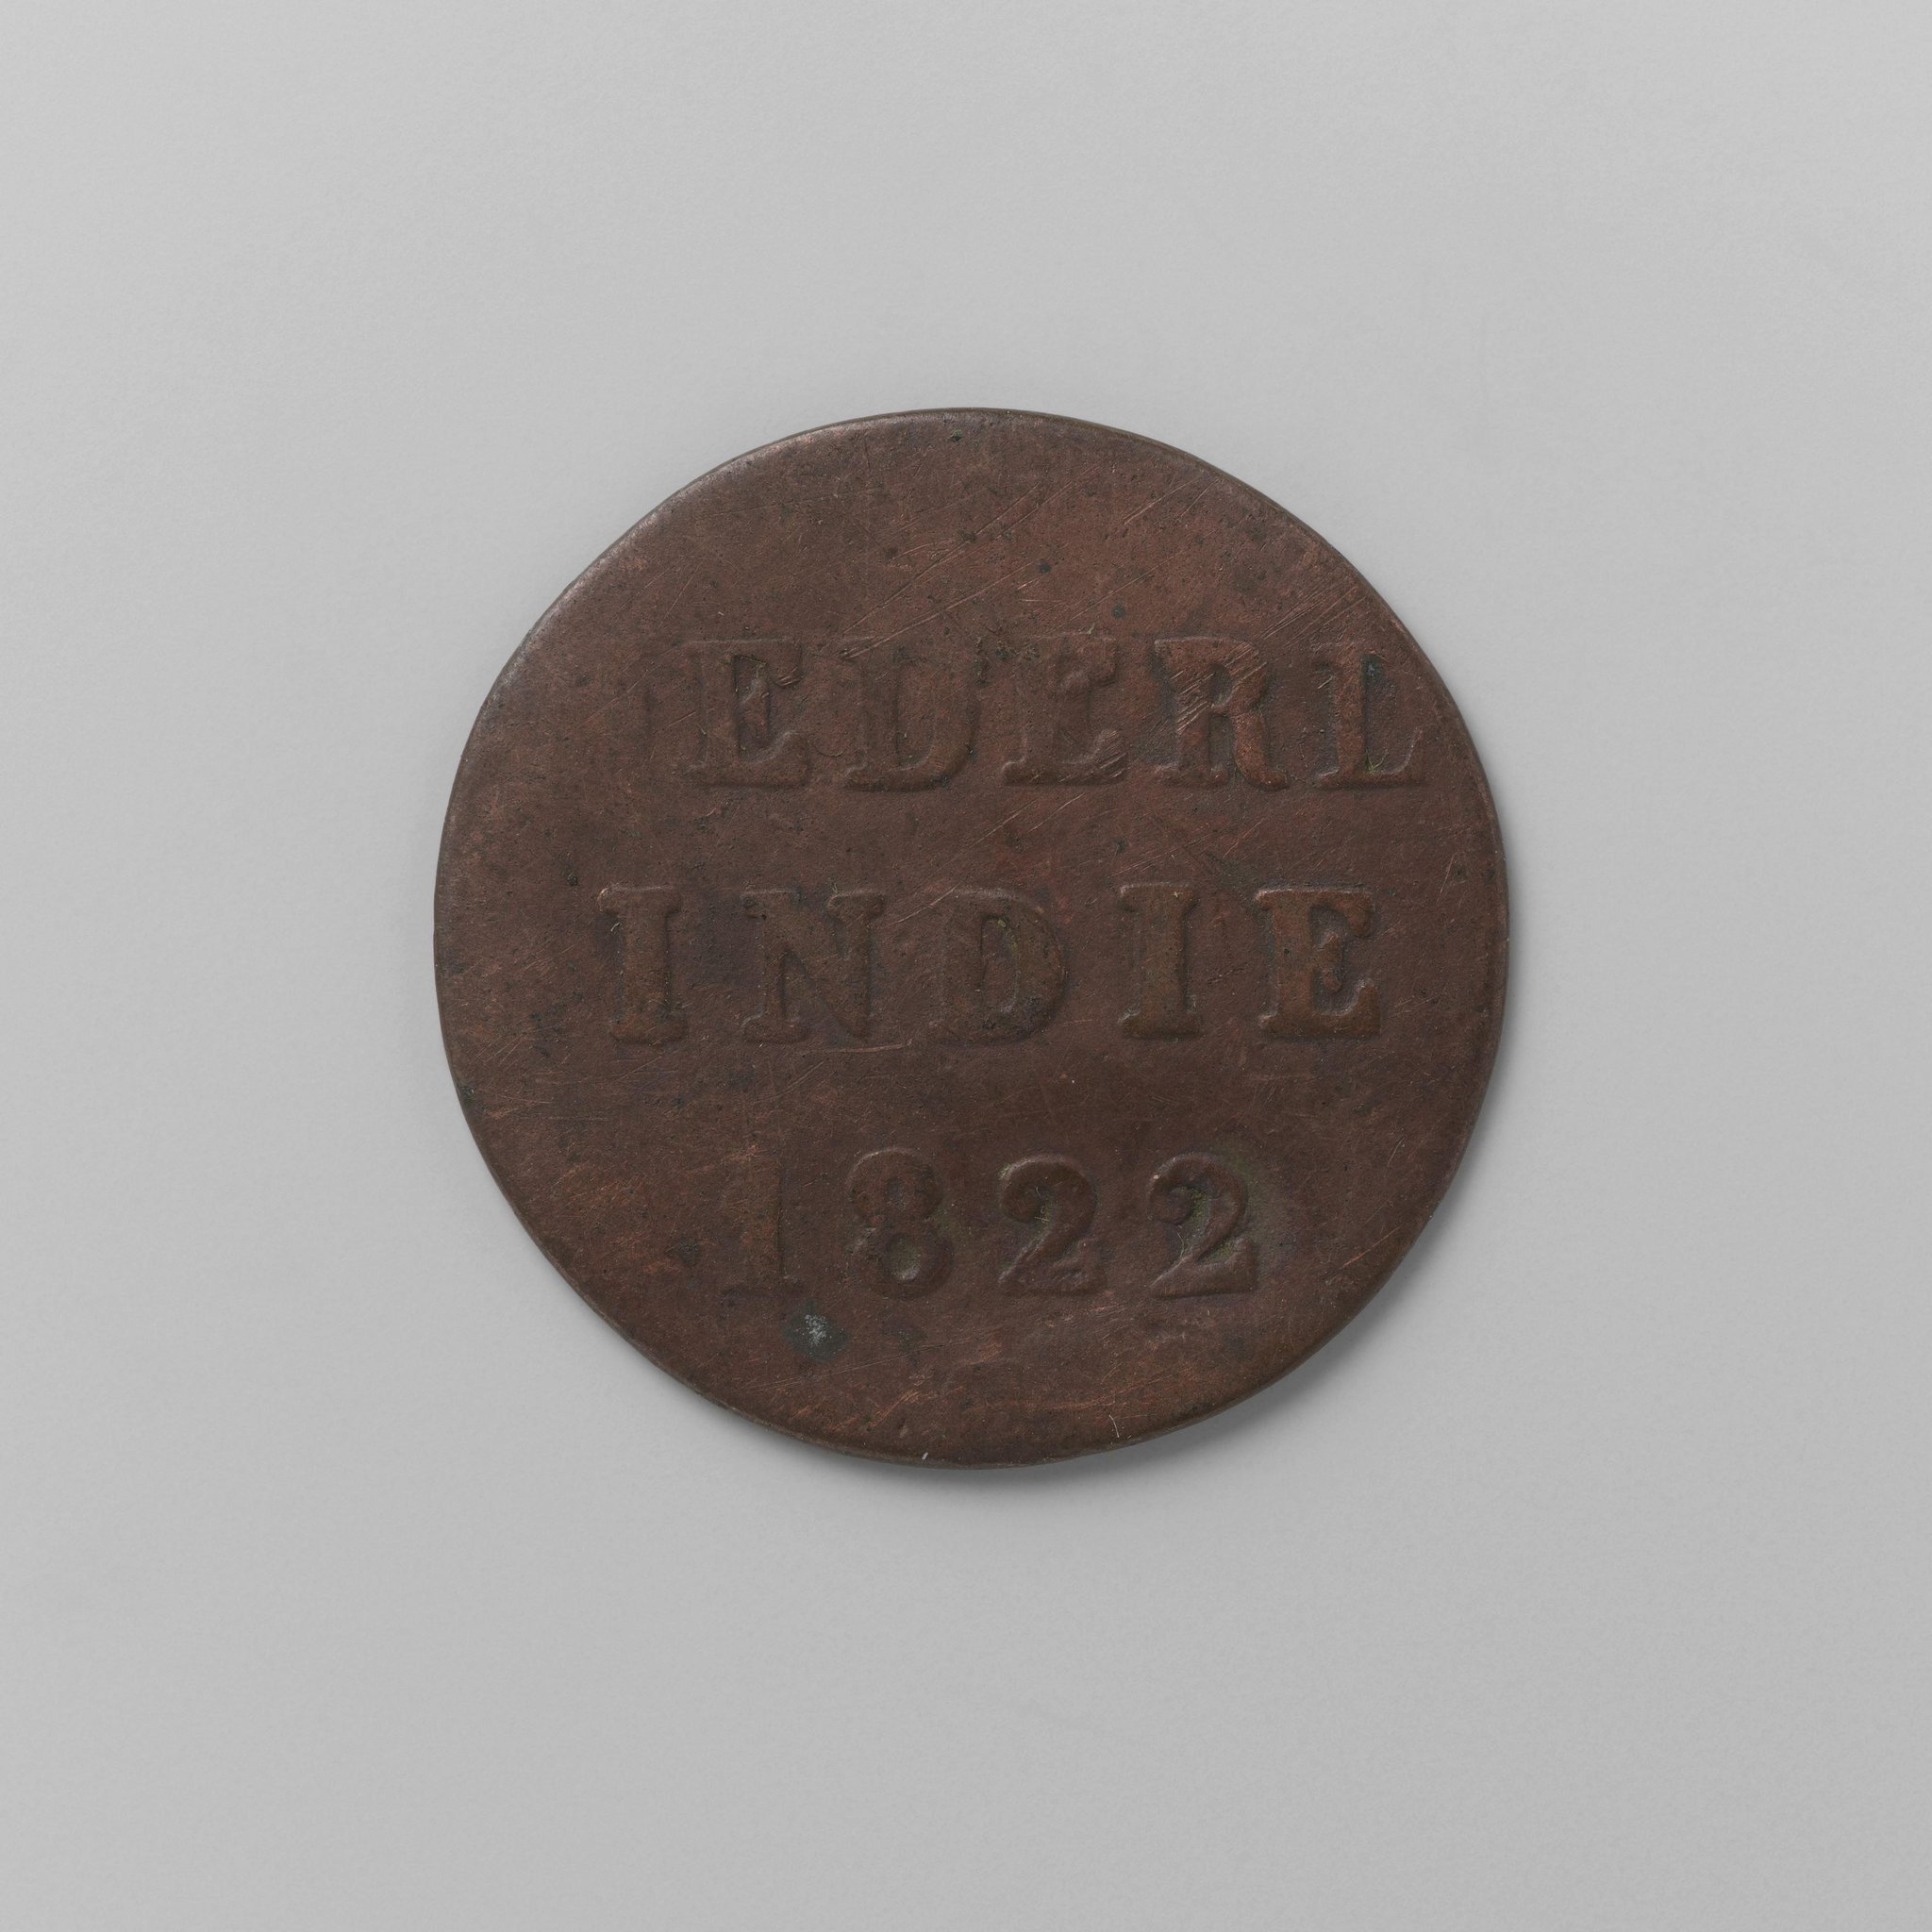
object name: coin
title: Nederlands Indië, 1/8 stuiver,1822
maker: william i of the netherlands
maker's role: koning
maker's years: 1772-1843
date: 1822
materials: copper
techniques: striking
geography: utrecht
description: Koperen munt. Voorzijde: tussen waarde-aanduiding 1/8 St. gekroond rijkswapenschild. Keerzijde: tweeregelig opschrift, waarboven muntteken en waaronder jaartal. Daaronder muntmeesterteken S [=Suermondt]. Gladde rand.